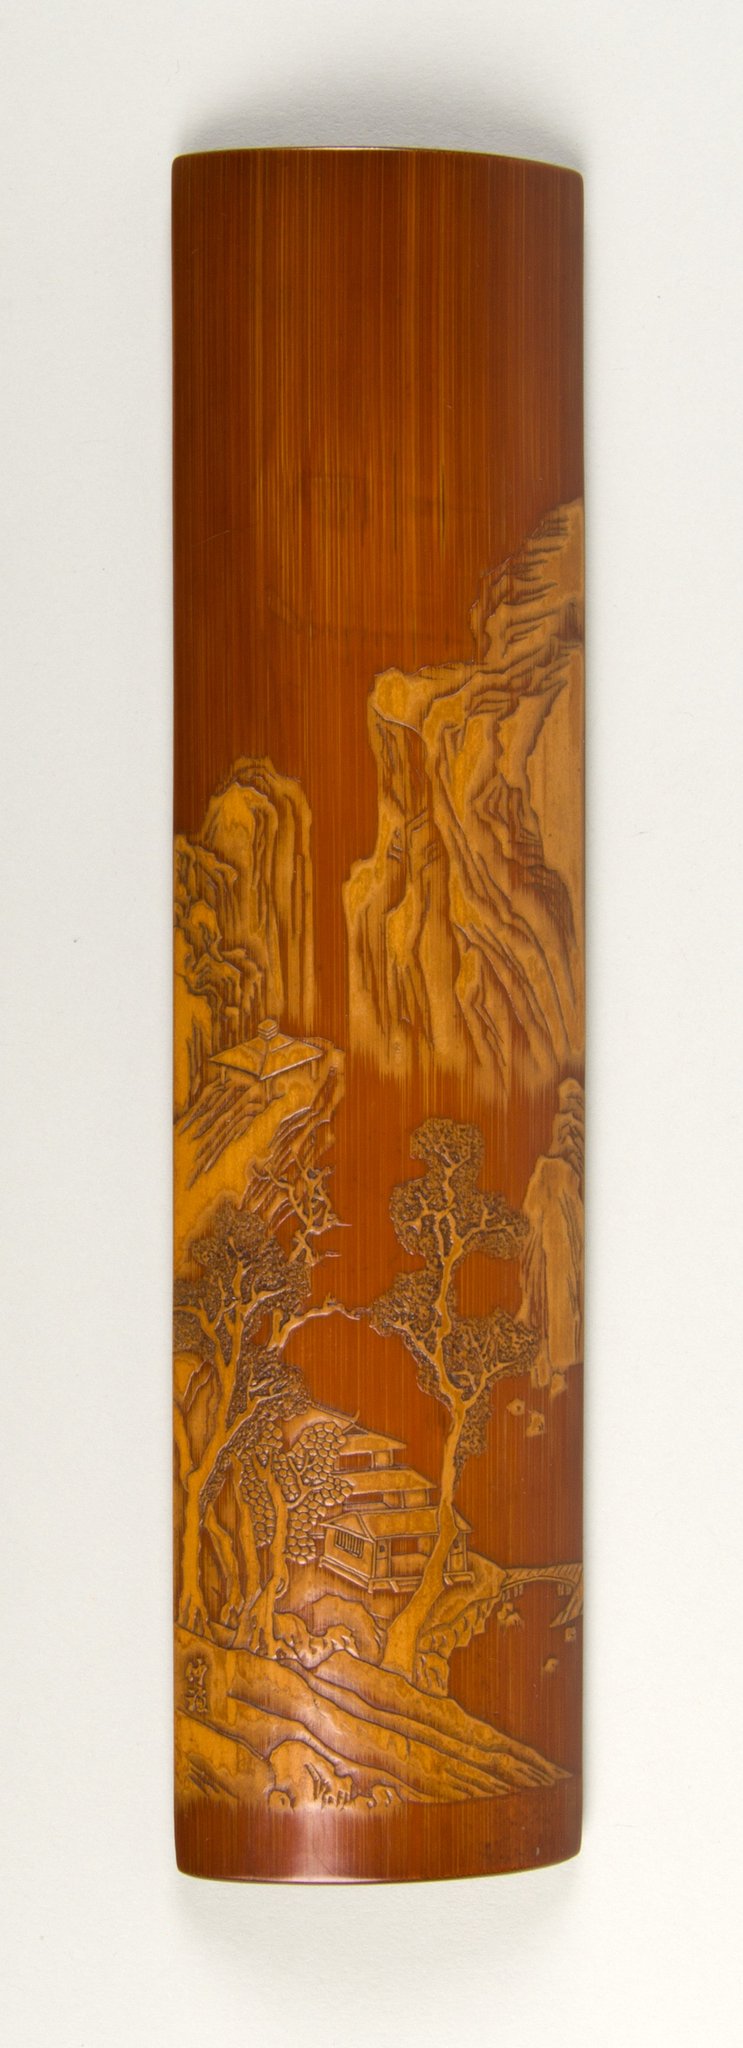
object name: wrist rest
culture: chinese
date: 1736-1795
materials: bamboo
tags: houses,trees